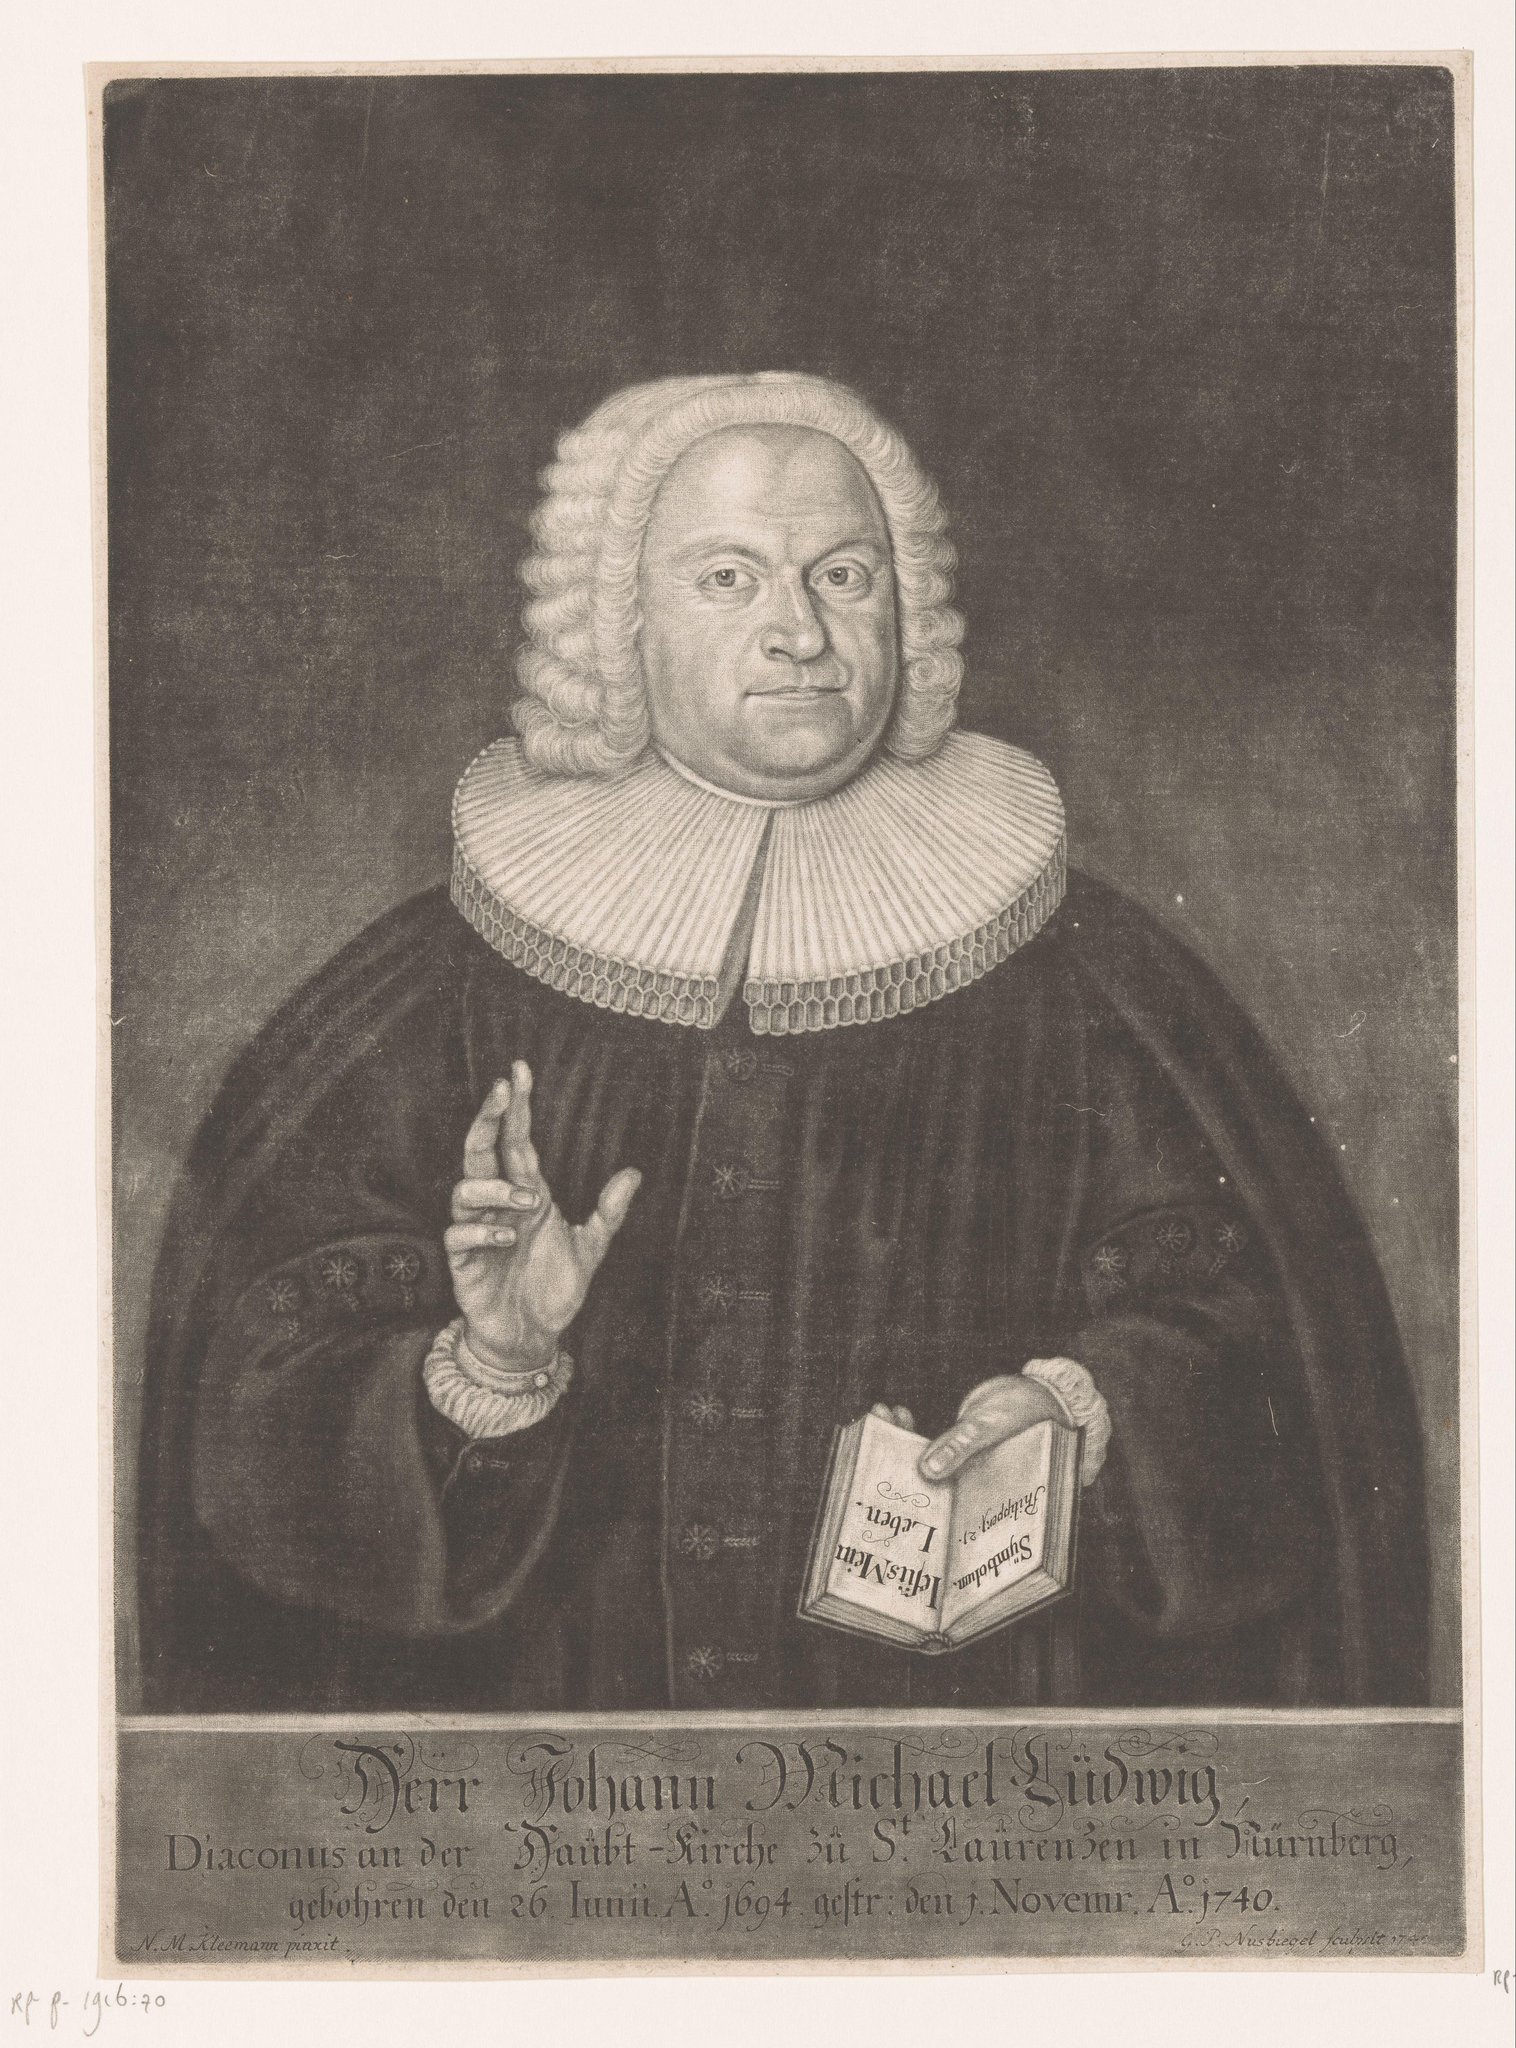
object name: print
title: Portret van Johann Michael Ludwig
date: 1740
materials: paper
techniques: mezzotint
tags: historical persons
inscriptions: collector's mark: Lugt 2228